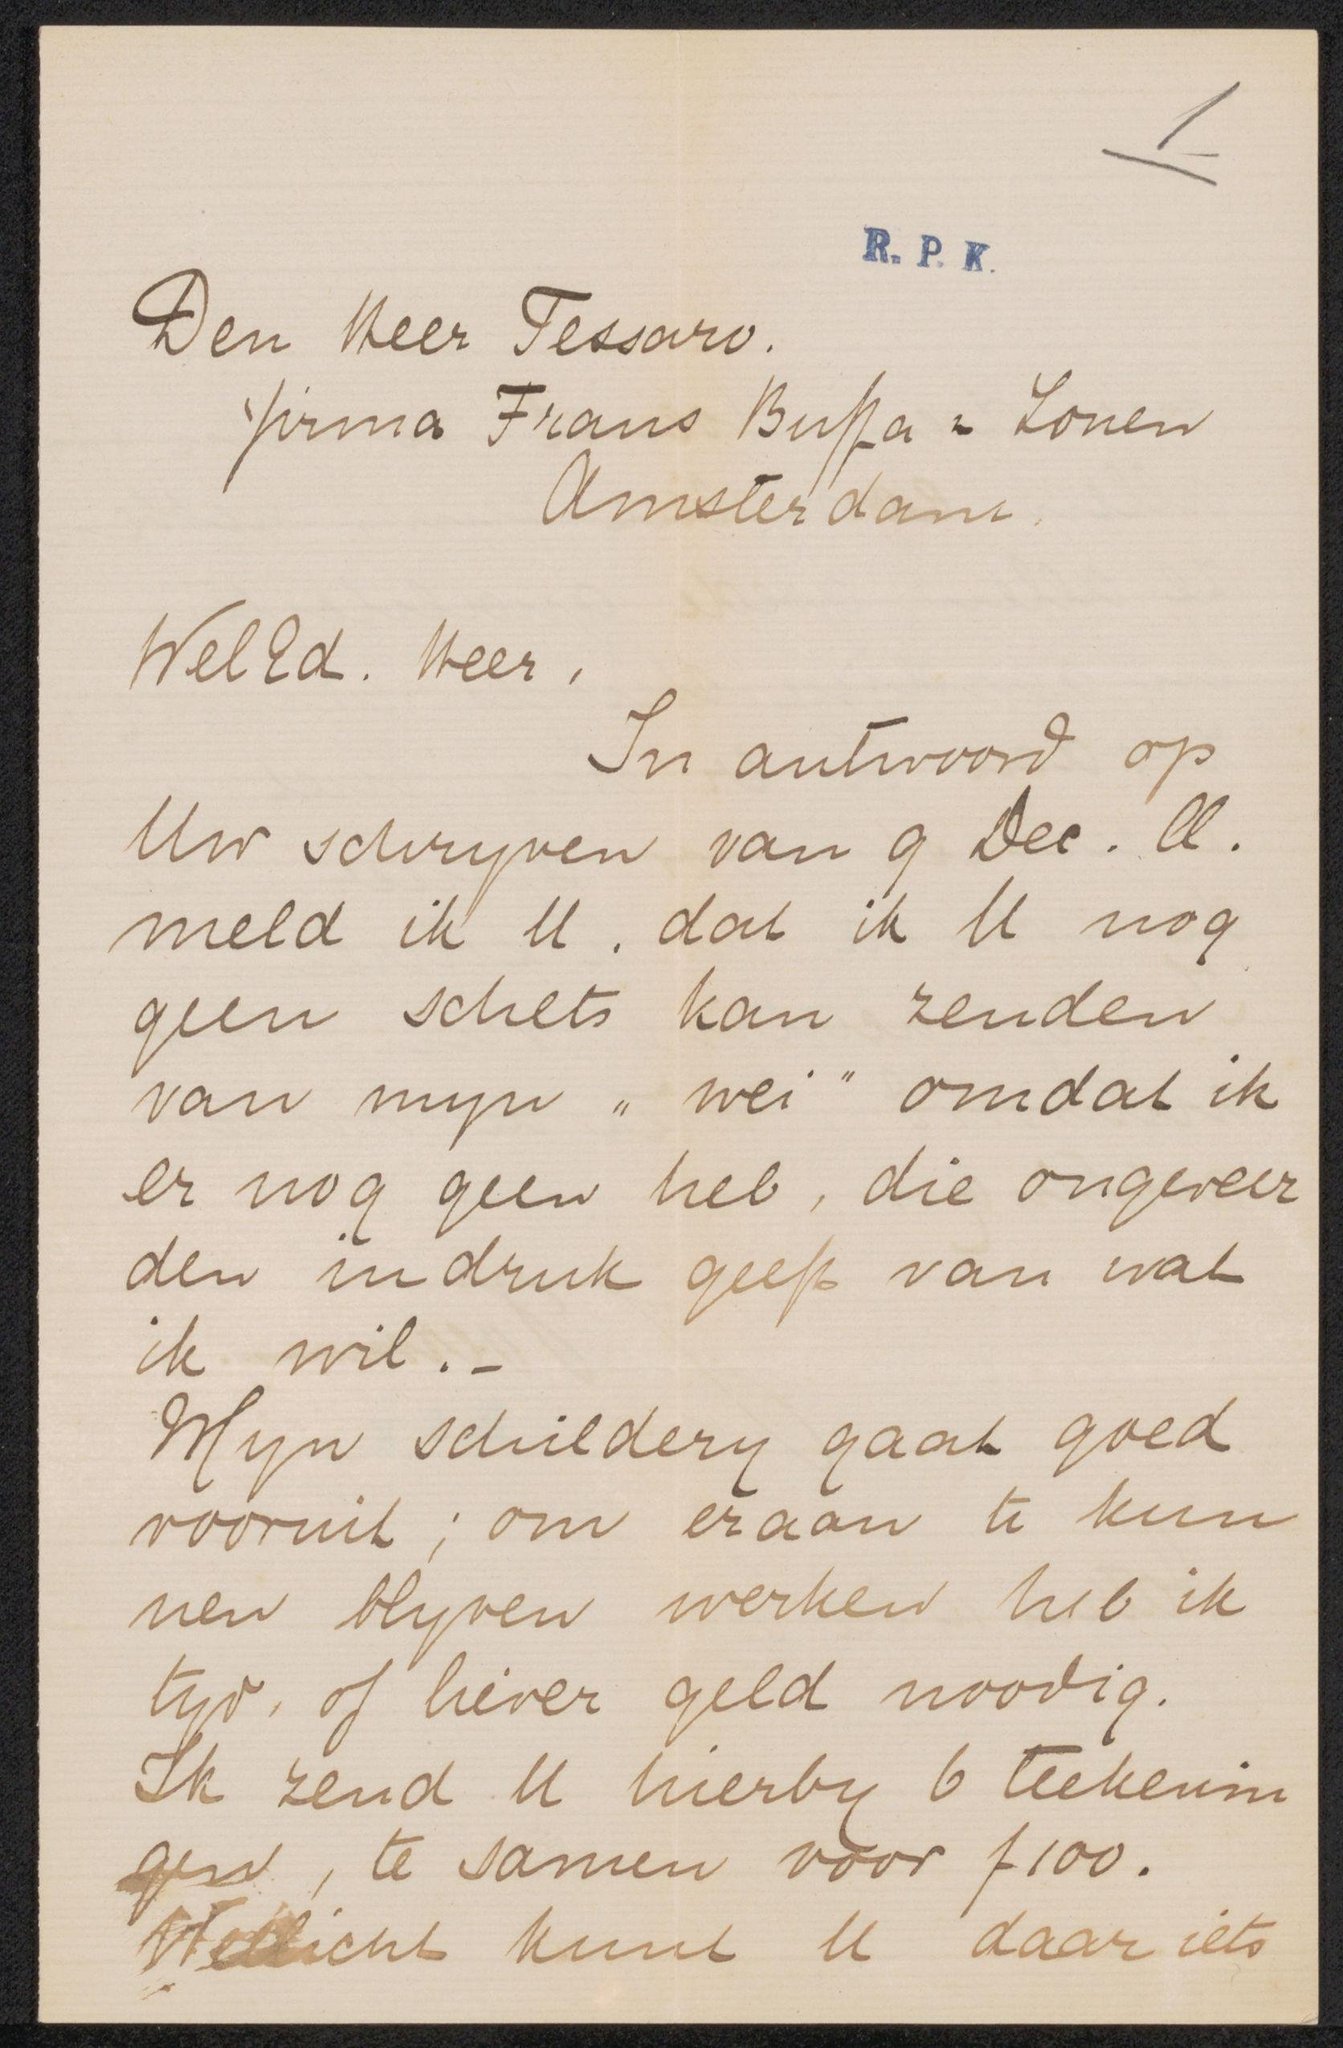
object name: letter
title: Brief aan Filippo Tessaro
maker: jan voerman (1857-1941)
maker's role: draughtsman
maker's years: 1857-1941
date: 1890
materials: ink, paper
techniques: pen, writing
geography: hattem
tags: amsterdam, publisher, drawing, painting (including book-illumination, miniature-painting), money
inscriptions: collector's mark: Lugt 2233